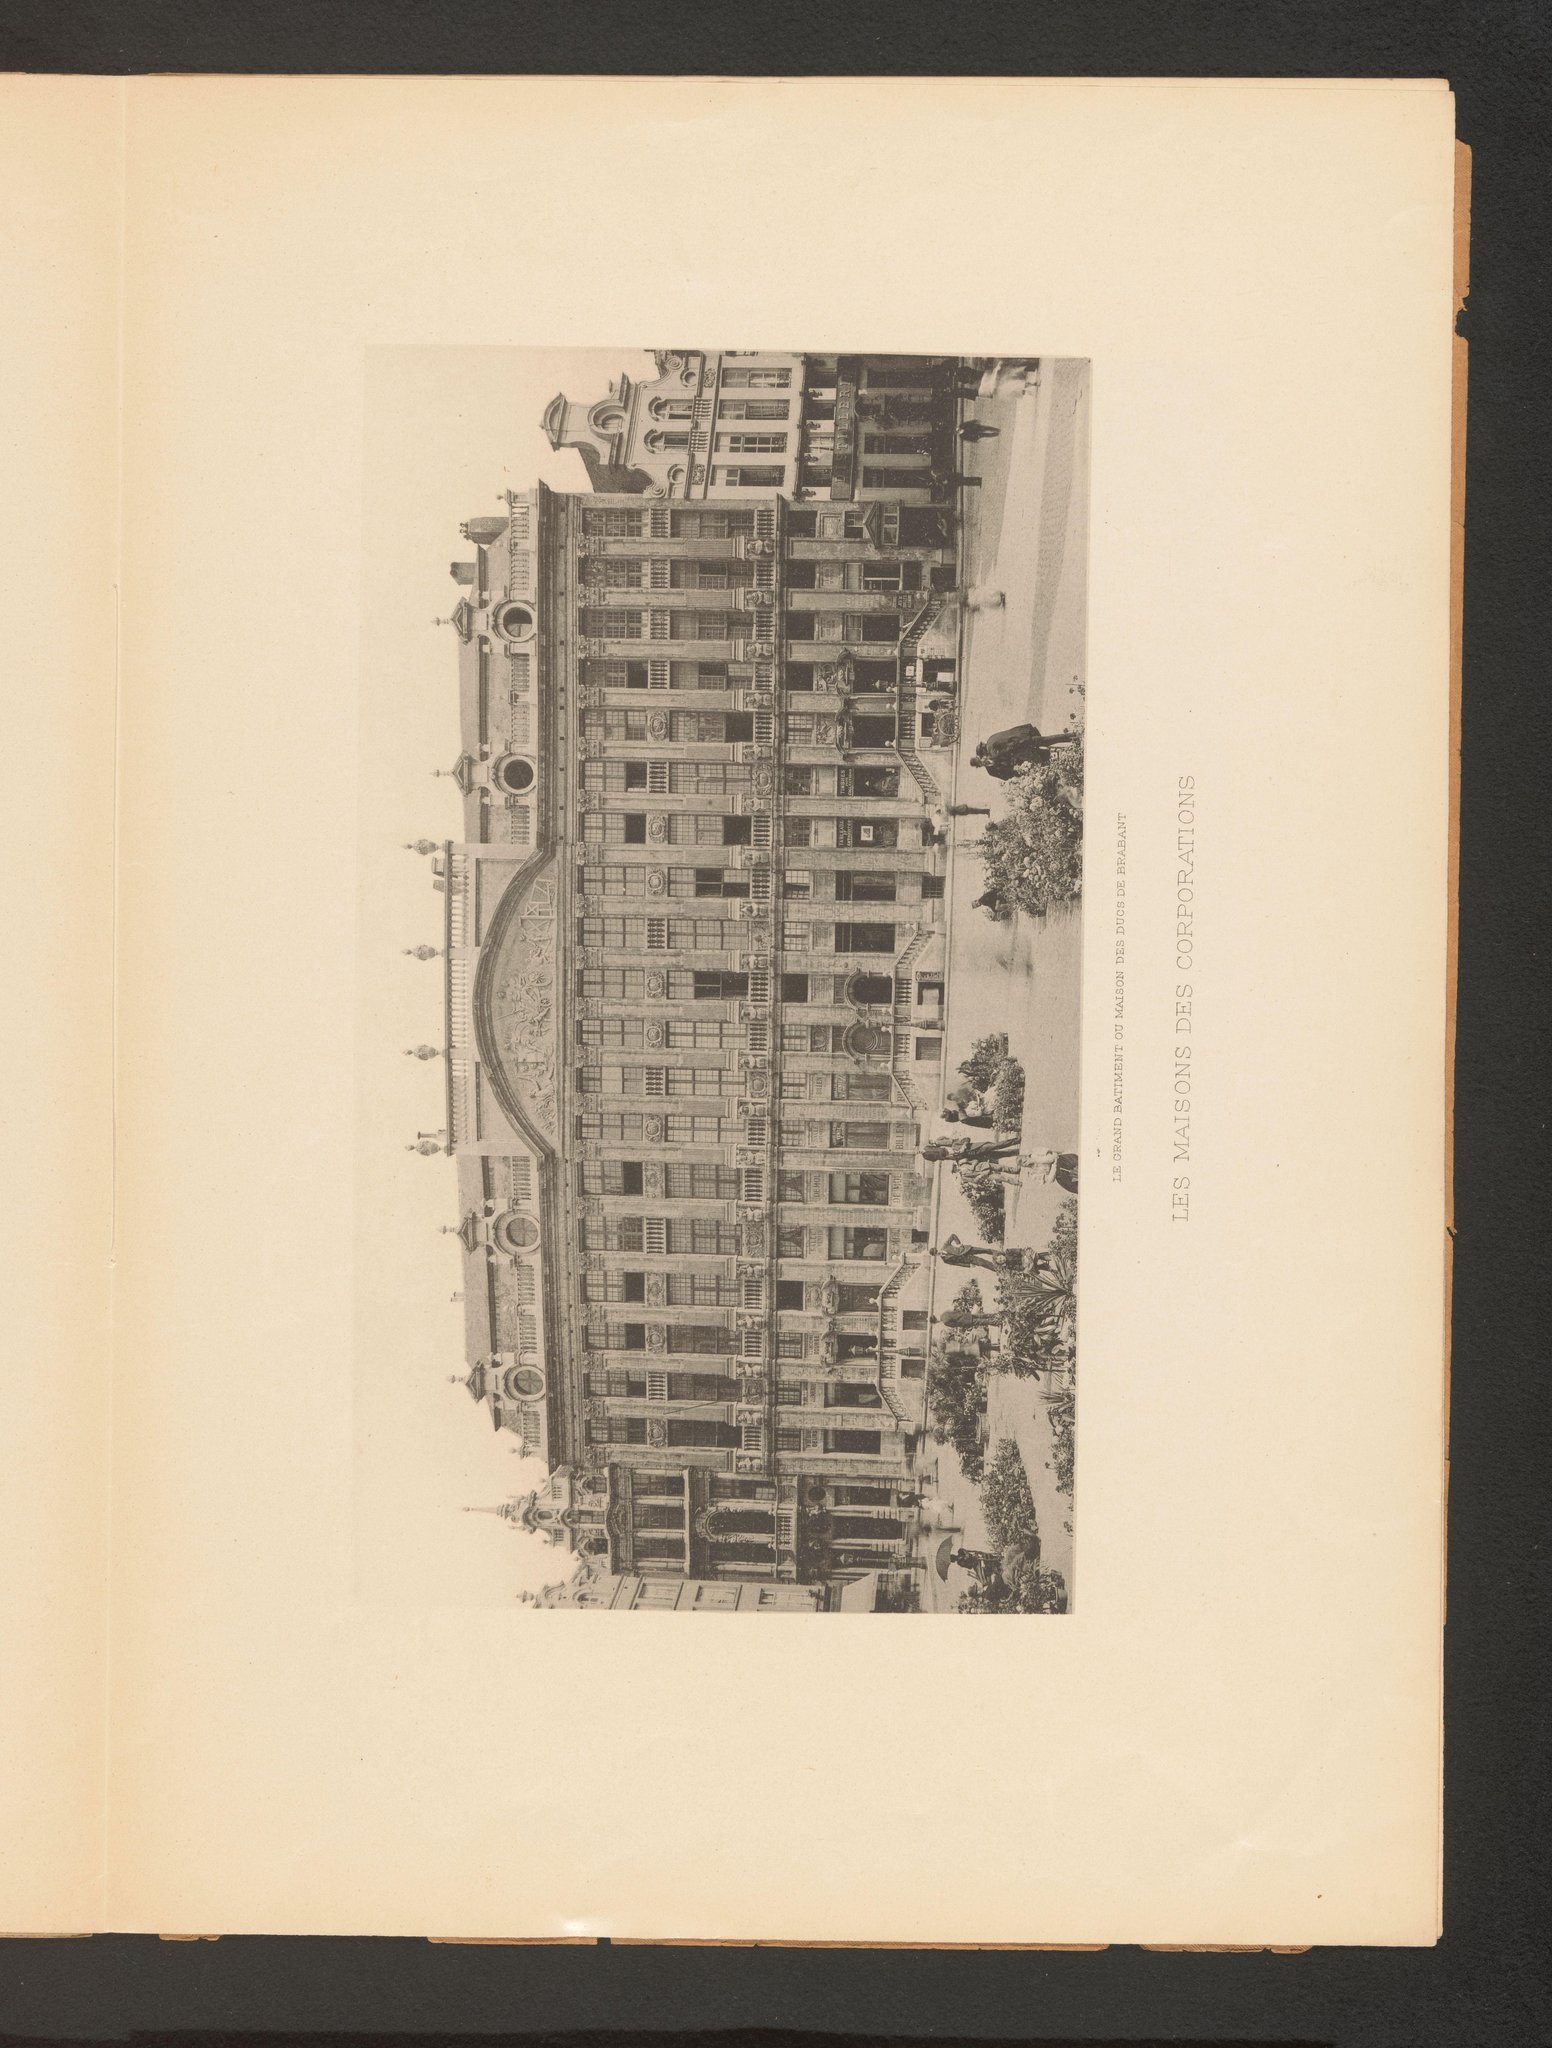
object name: page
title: Gezicht op het Huis van de Hertogen van Brabant aan de Grote Markt in Brussel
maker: Anonymous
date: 1894-1899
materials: paper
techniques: photograph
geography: brussels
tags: corporative organization, guild, civic architecture; edifices; dwellings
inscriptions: inscription: ‘Le Grand Batiment ou Maison des Ducs de Brabant’